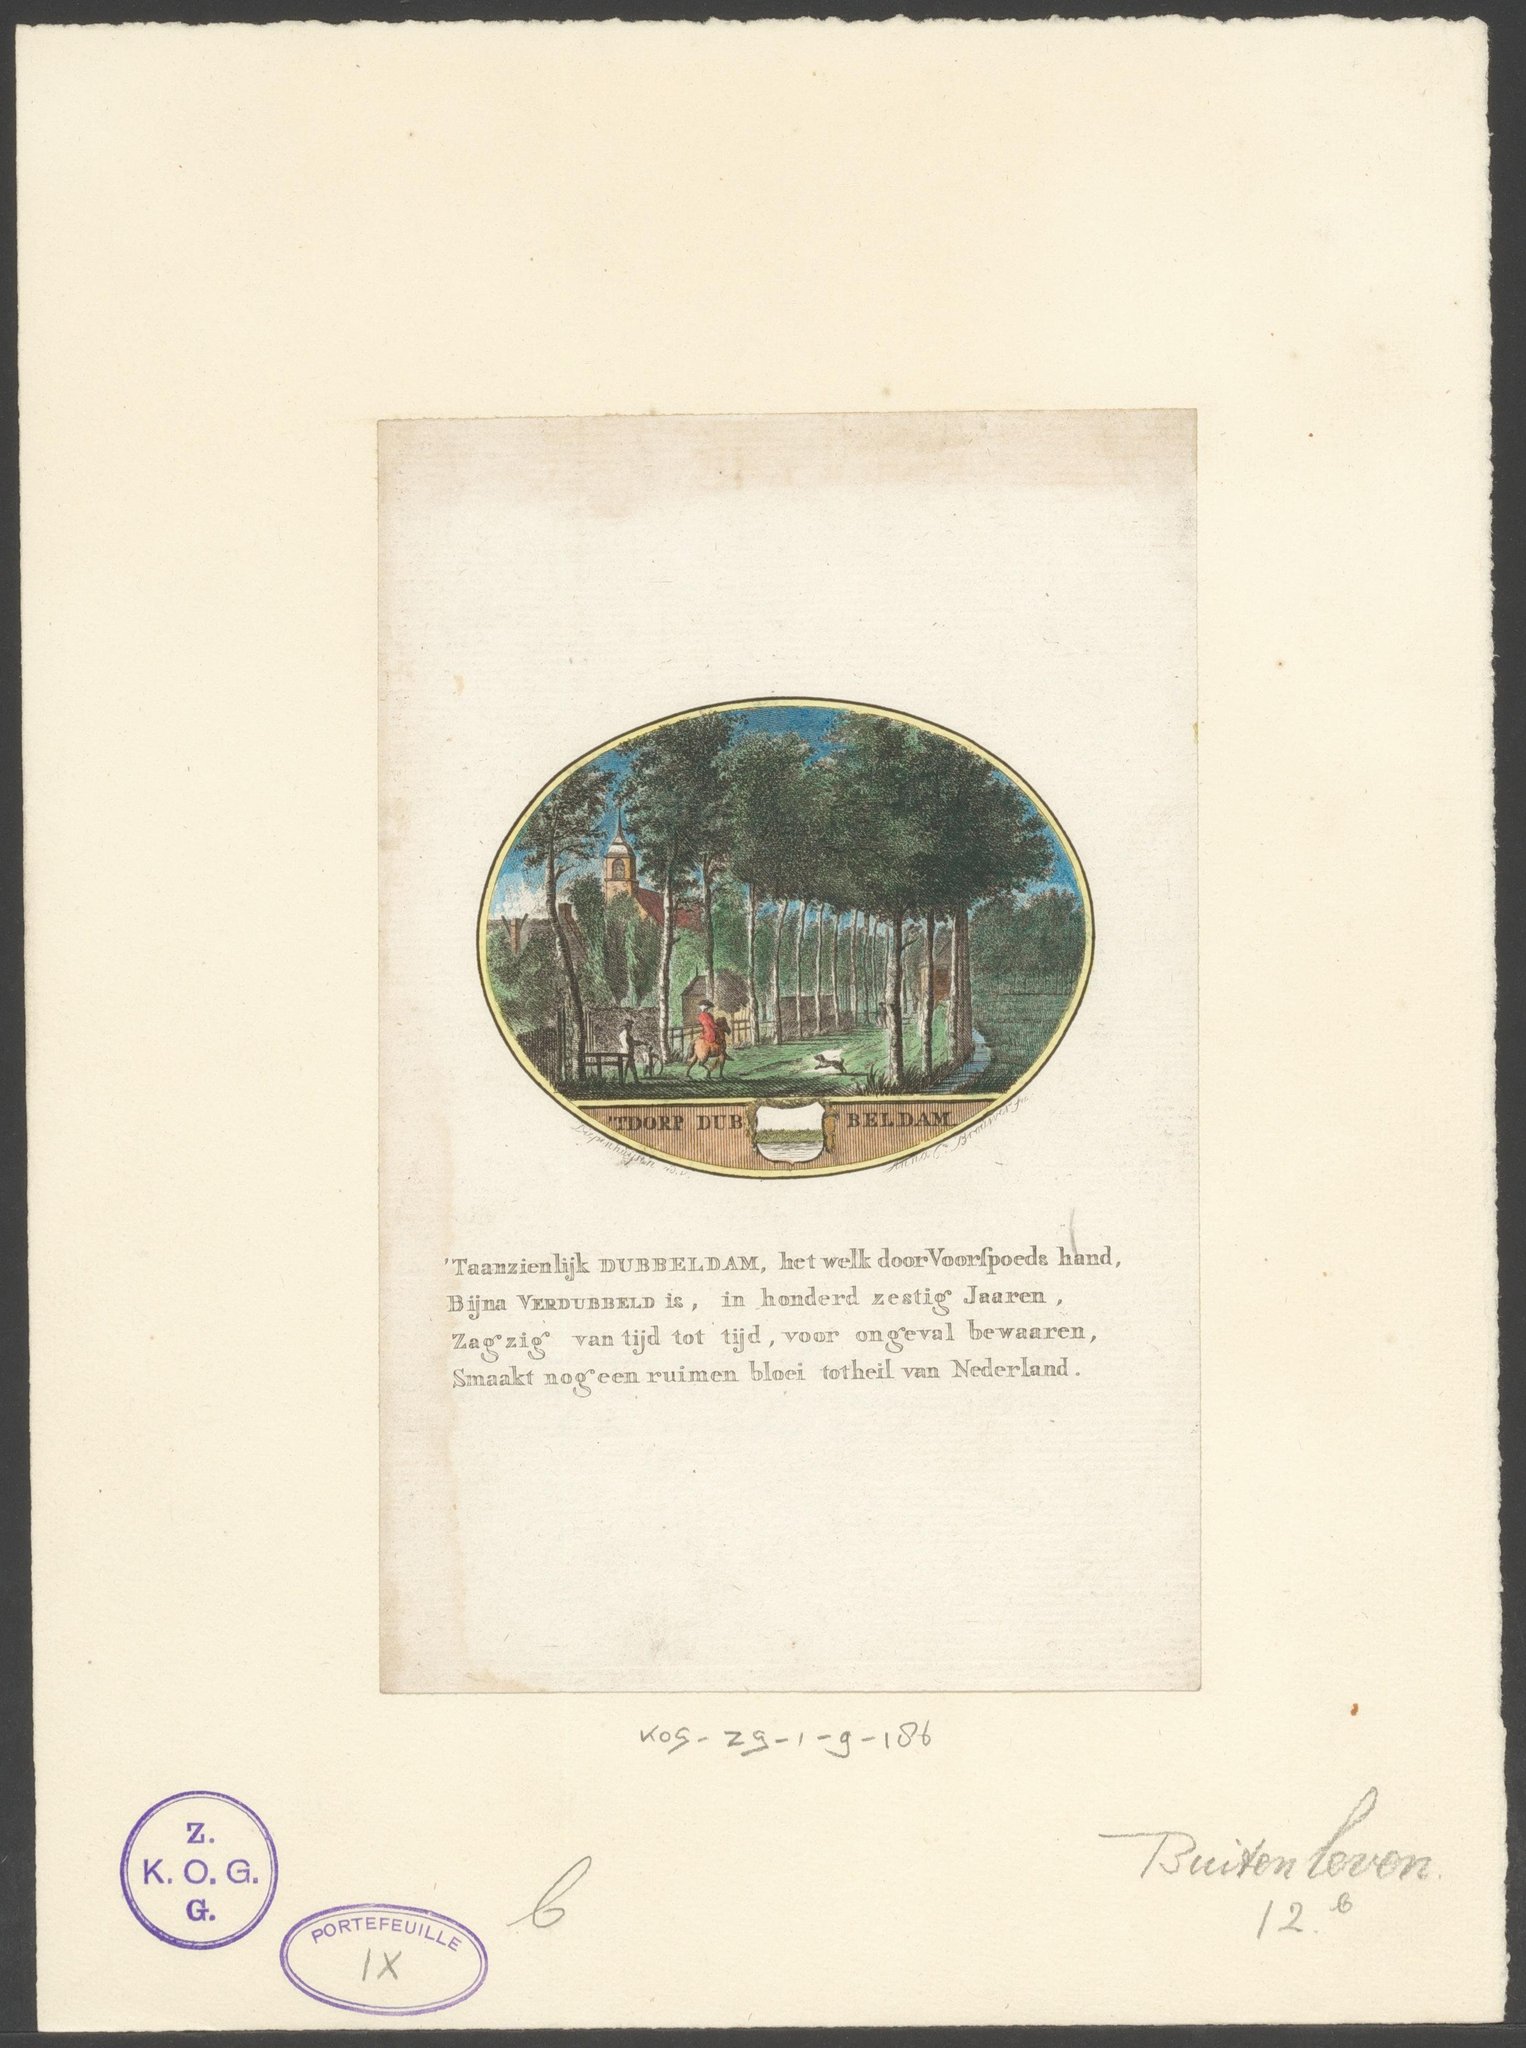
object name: print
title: Gezicht op de laan naar Dubbeldam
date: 1791-1793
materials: paper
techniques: etching, hand coloring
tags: city-view, and landscape with man-made constructions, village street, church (exterior), lane, alley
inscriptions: collector's mark: Lugt 1641, stamp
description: Gezicht op de laan naar Dubbeldam. Onderaan een vierregelig vers. Onderwerpsrubrieken binnen de Atlas Zeden en Gewoonten: Handel, nijverheid en verkeer, Buitenleven.